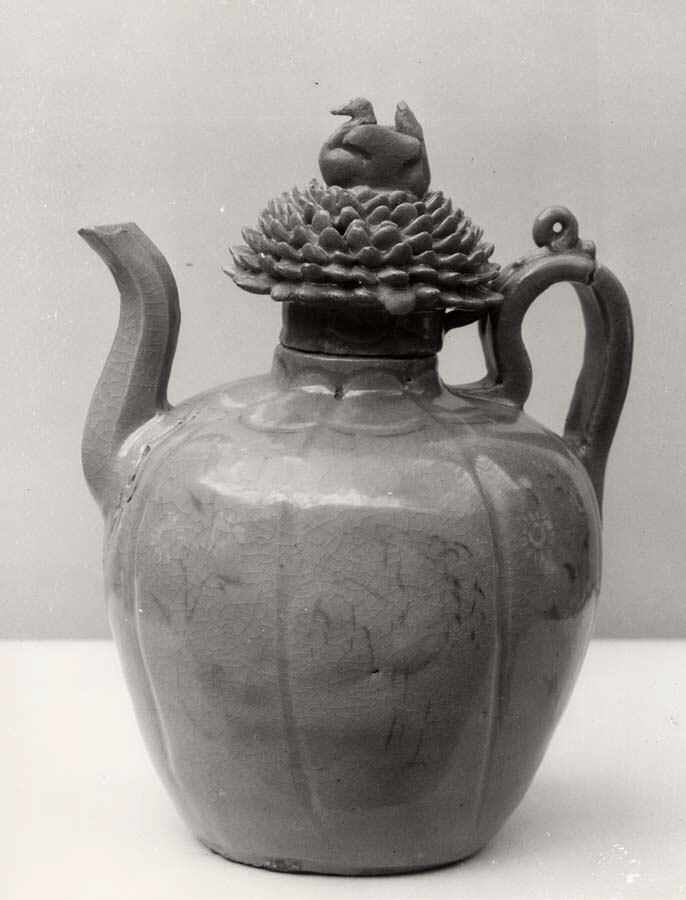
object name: wine pot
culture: korean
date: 1101-1300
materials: clay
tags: ducks